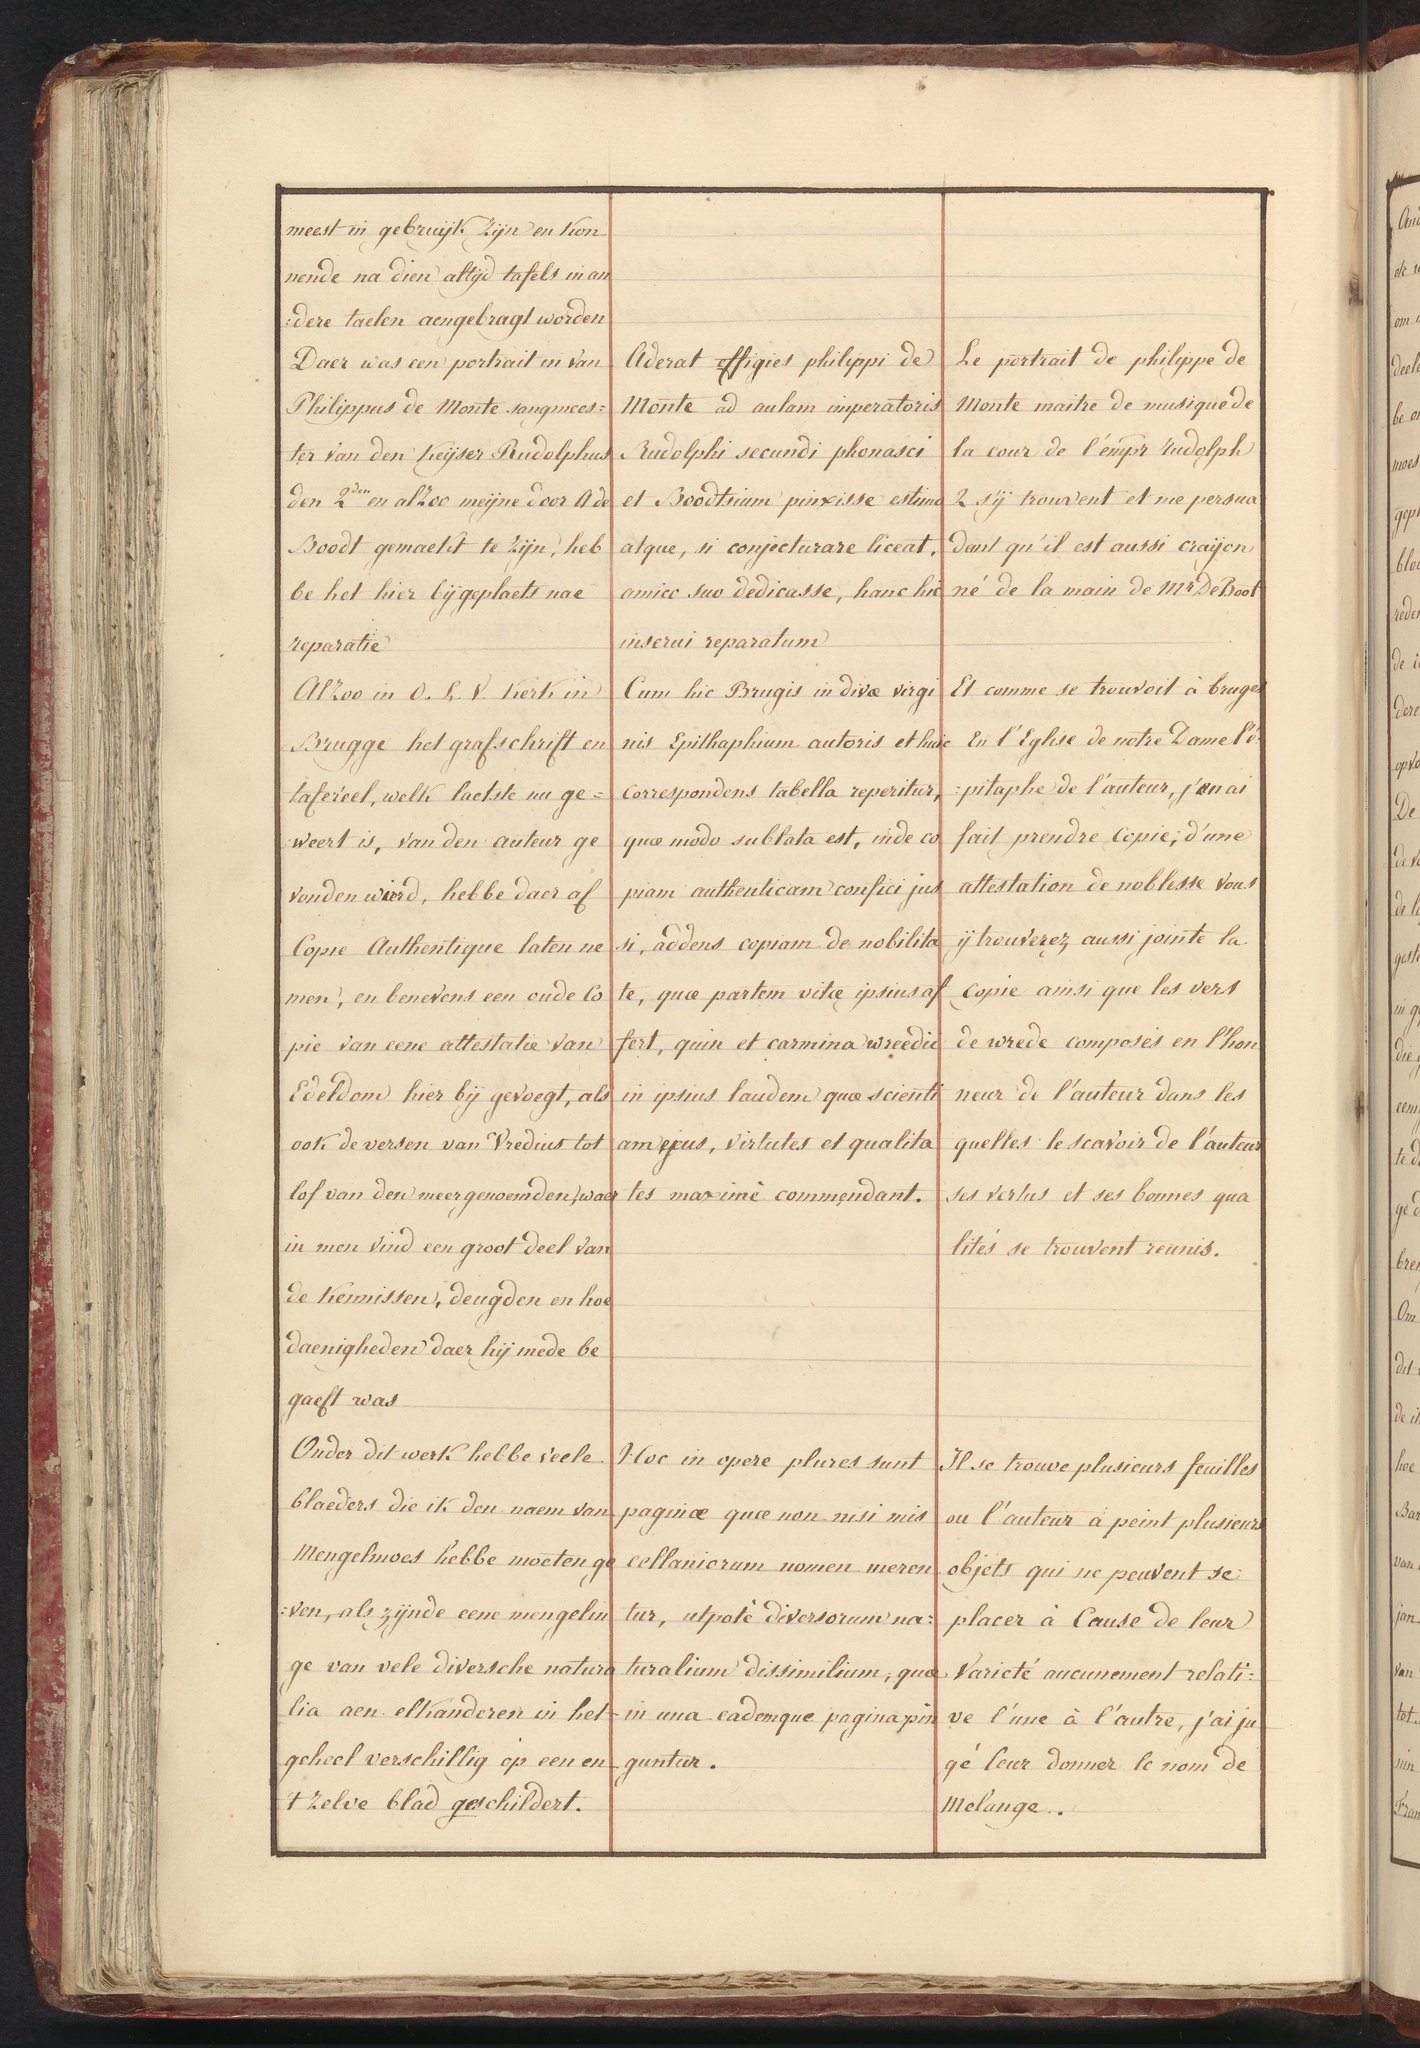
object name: manuscript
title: Vervolg van het bericht aan de liefhebber van de natuurlijke historie (vierde bladzijde)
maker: joseph van huerne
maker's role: kunstliefhebber, mecenas, verzamelaar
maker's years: 1752-1844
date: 1596-1610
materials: ink, paper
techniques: pen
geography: bruges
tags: handwriting, written text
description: Vervolg (vierde bladzijde) van de inleidende teksten in drie kolommen in het Nederlands, Latijn en Frans, waarin de samensteller van de albums zich tot de lezer richt. Voor het begin zie p. 23. Onderdeel van het eerste album met tekeningen van viervoeters. Eerste van twaalf albums met tekeningen van dieren, vogels en planten bekend rond 1600, gemaakt in opdracht van keizer Rudolf II. Met toelichting in Nederlands, Latijn en Frans.